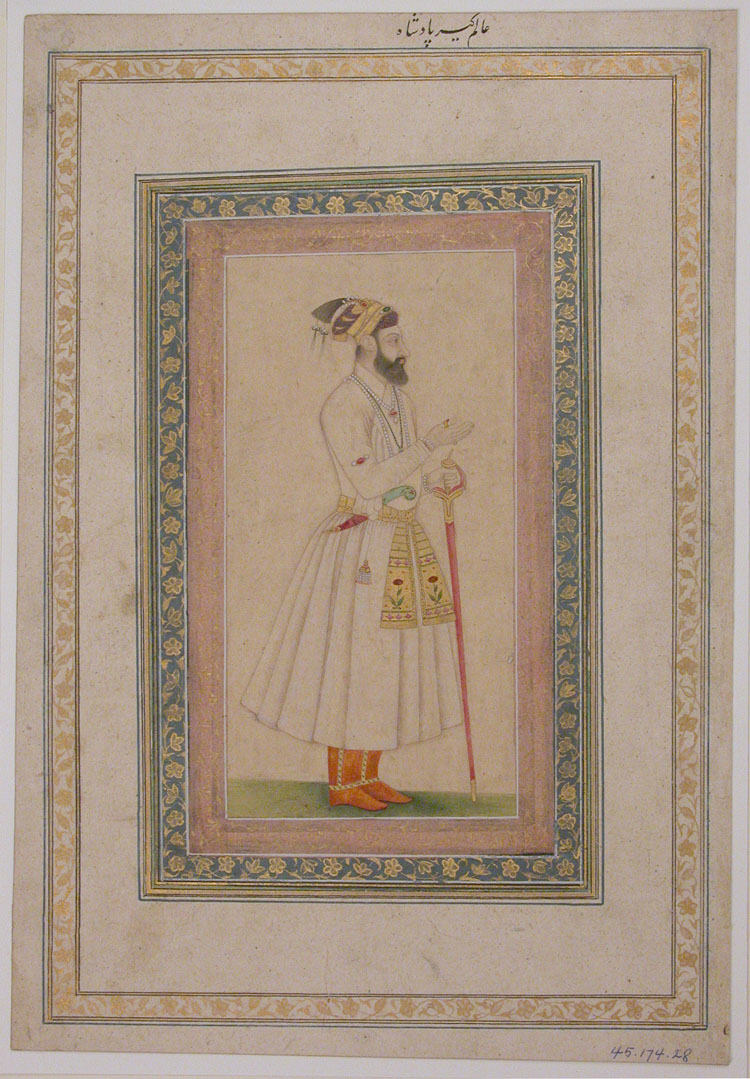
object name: album leaf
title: Portrait of the Emperor Aurangzeb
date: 1601-1700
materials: gold, ink, paper, watercolor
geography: india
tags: swords,men,profiles